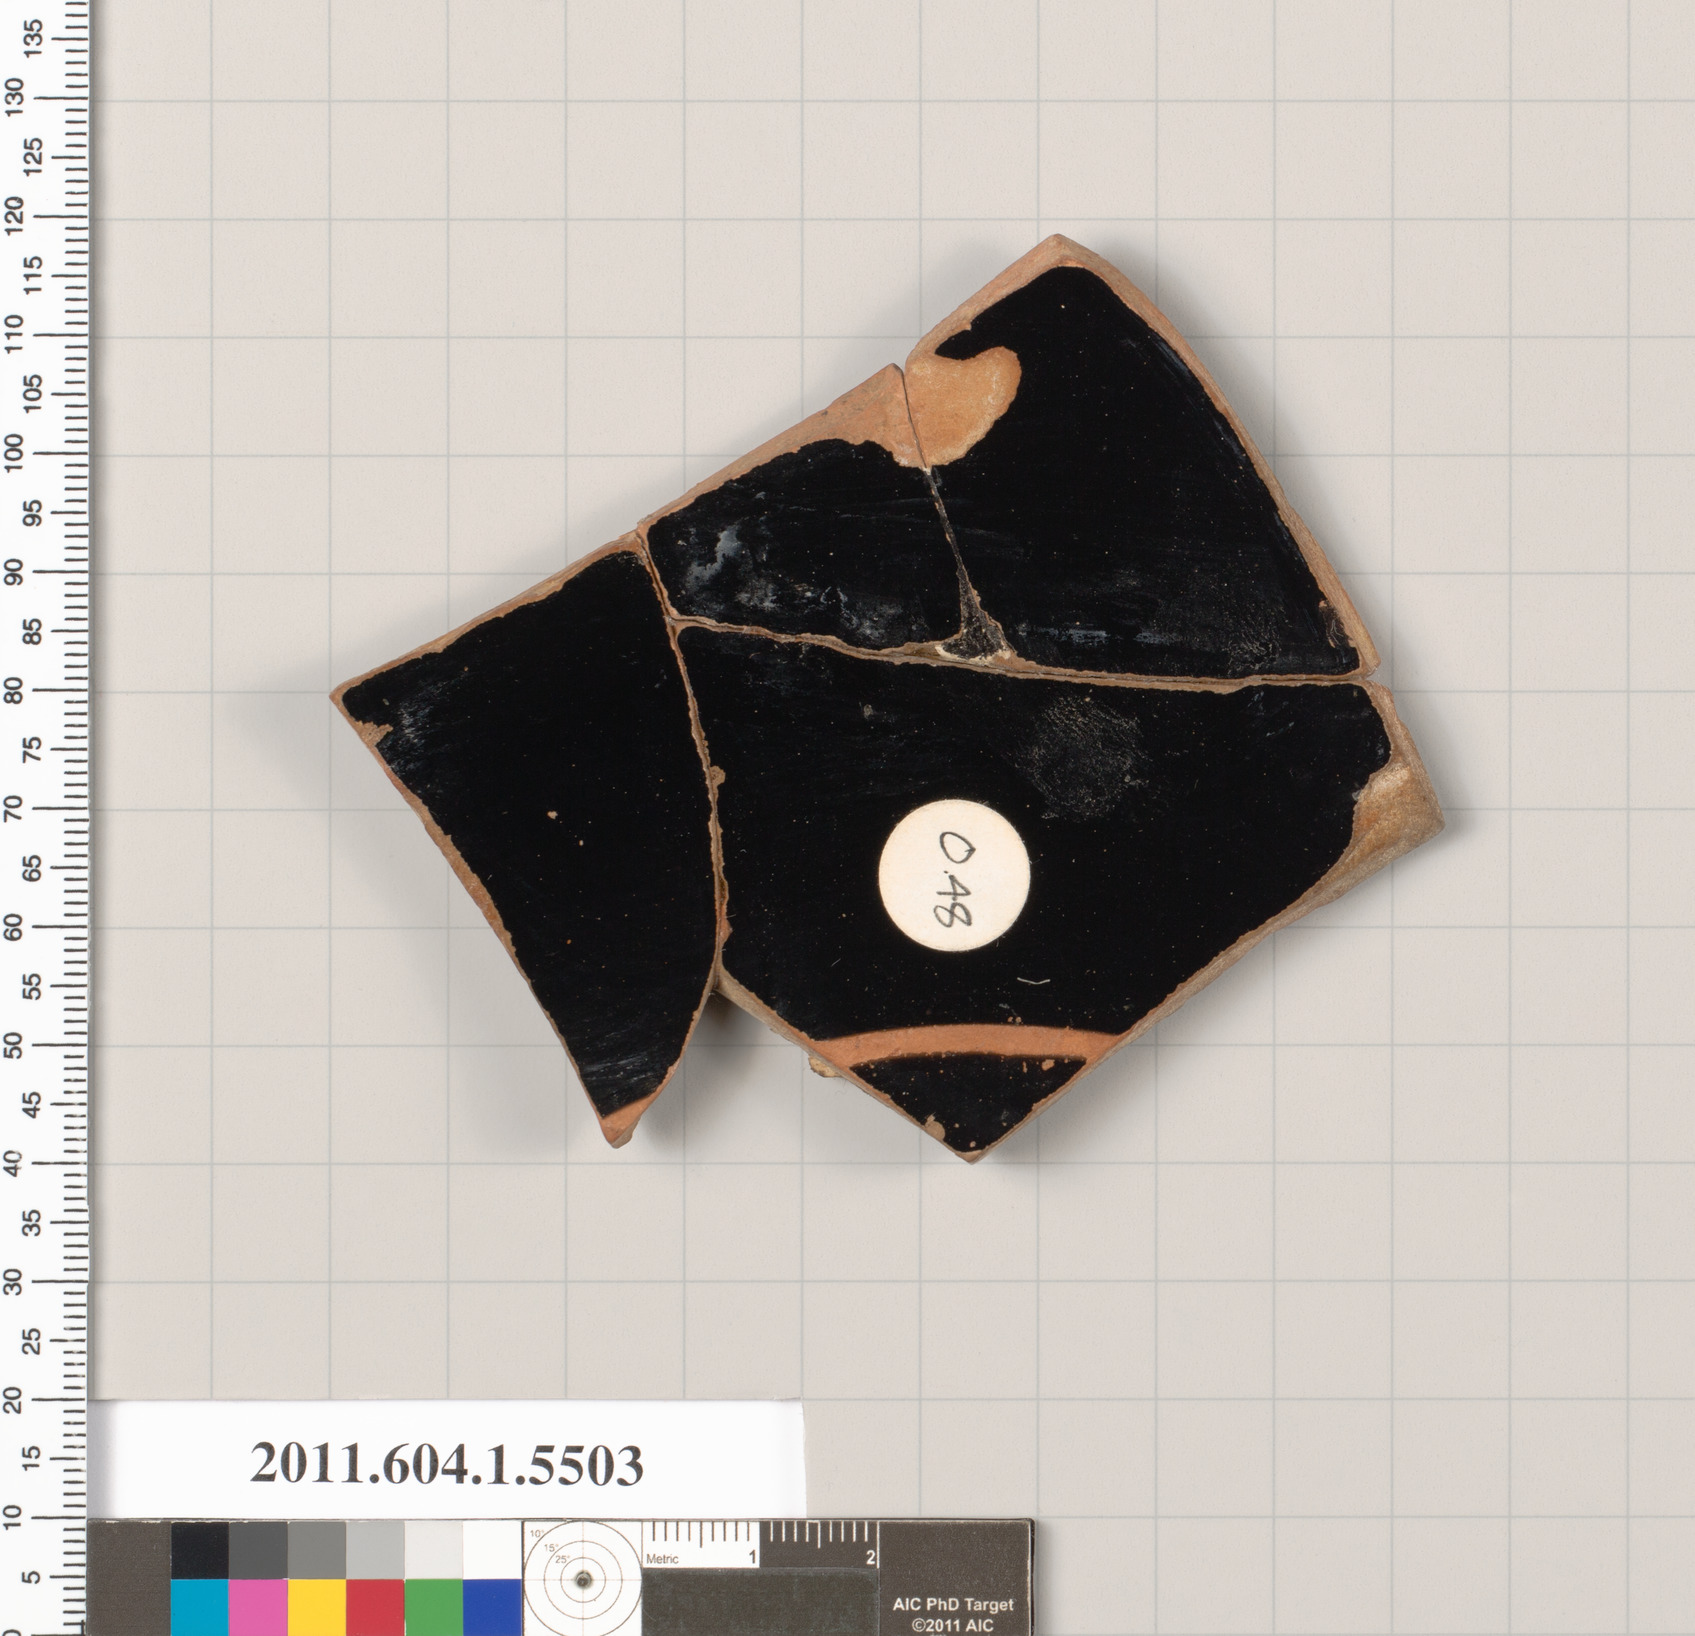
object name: kylix fragment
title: Terracotta fragment of a kylix (drinking cup)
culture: greek, attic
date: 520-510 BCE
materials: terracotta